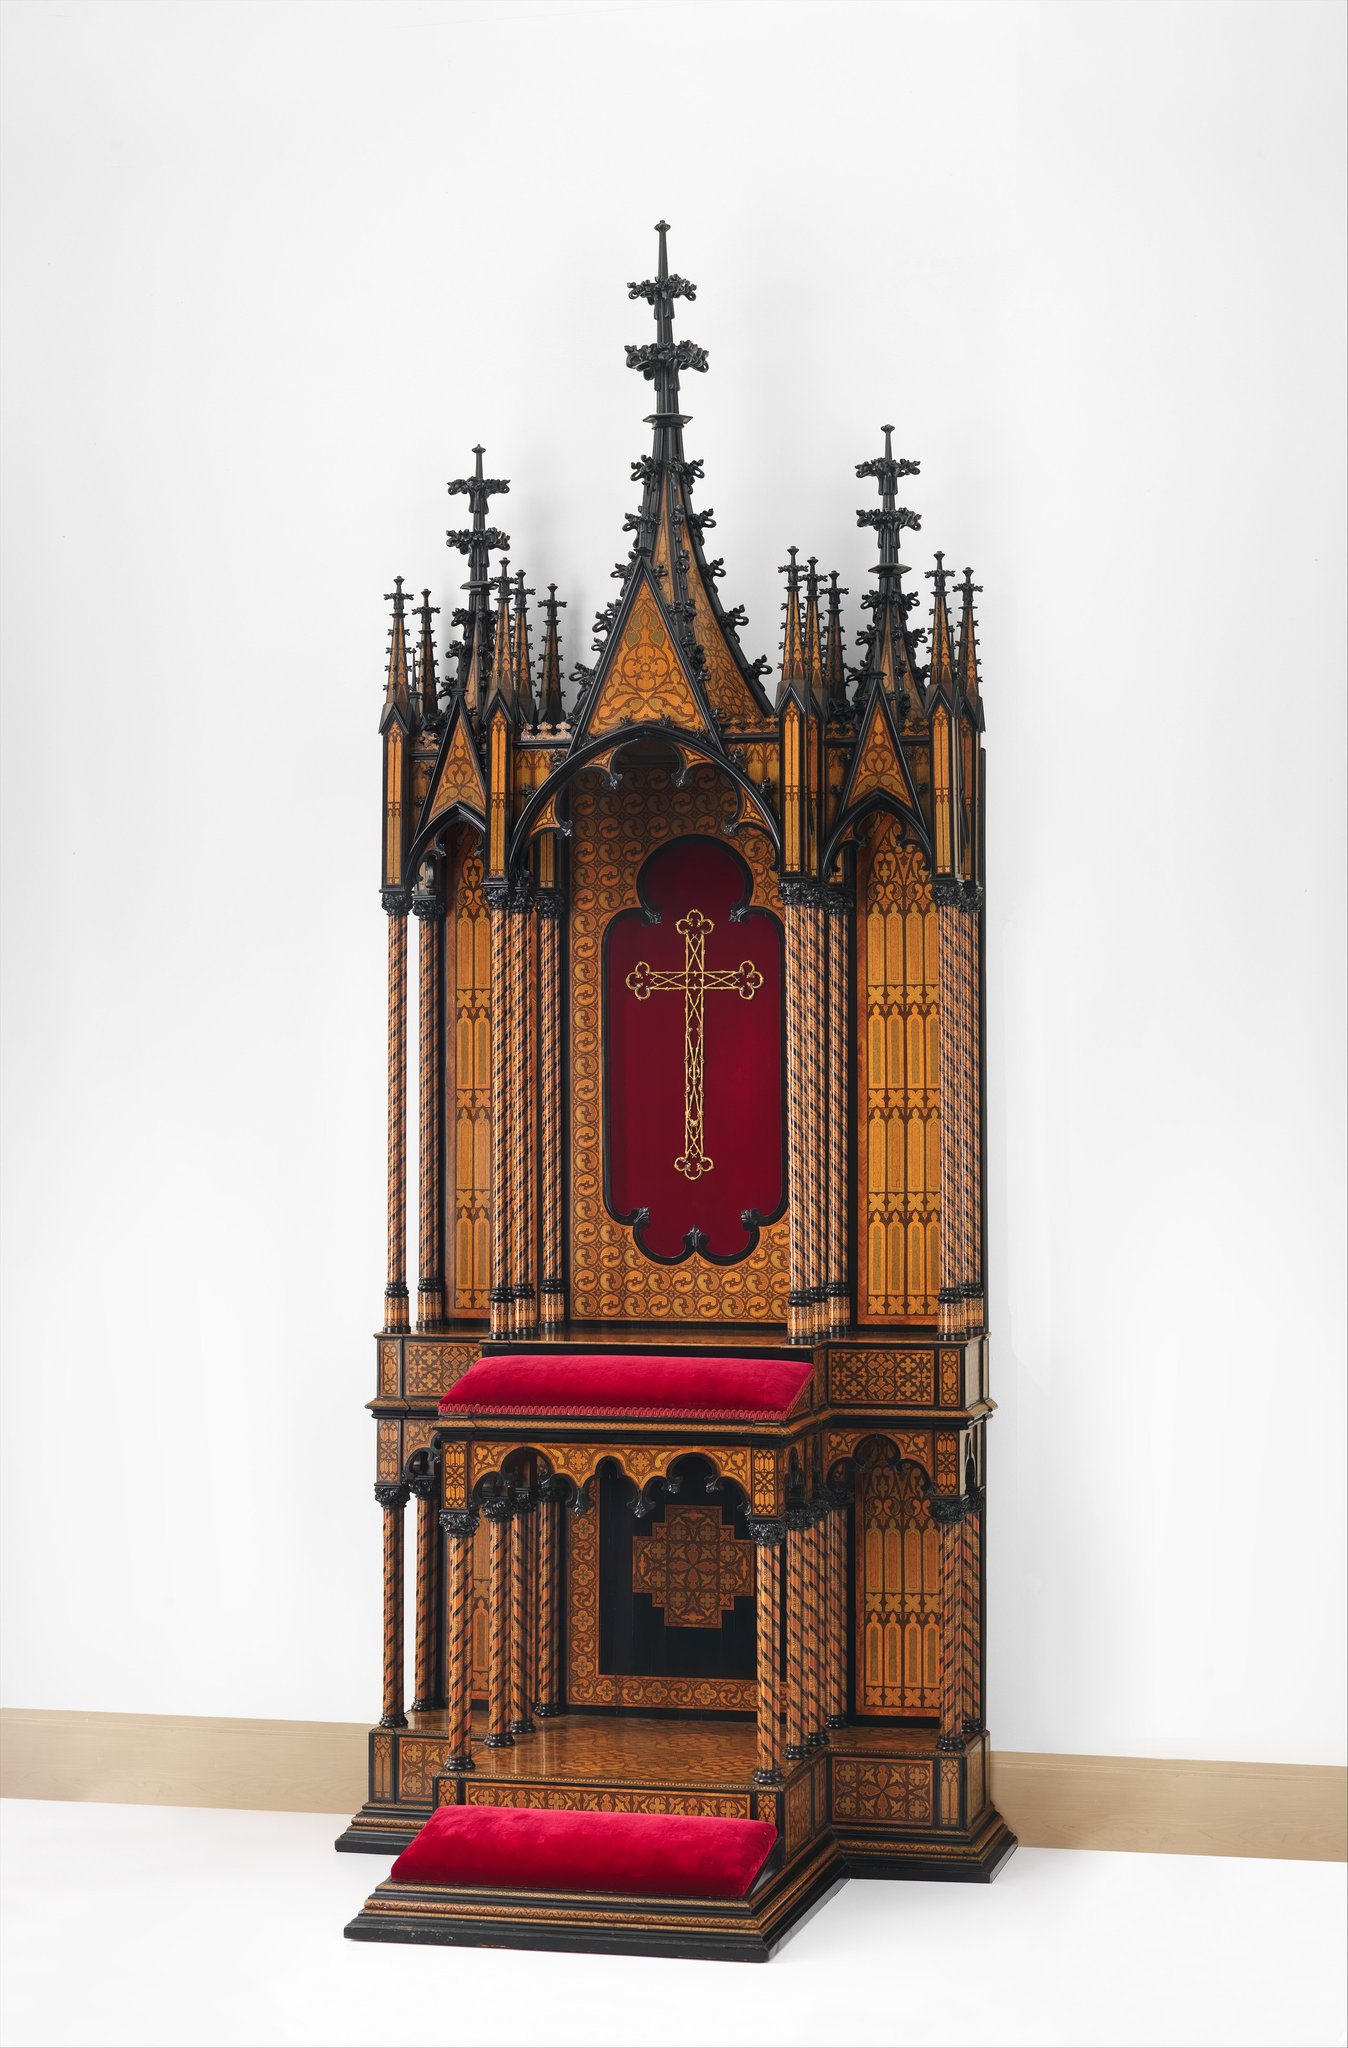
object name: prie dieu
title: Prie-dieu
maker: stammer & breul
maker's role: maker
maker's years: 1840-1860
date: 1855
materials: brass, wood, silk, velvet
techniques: stain, veneering